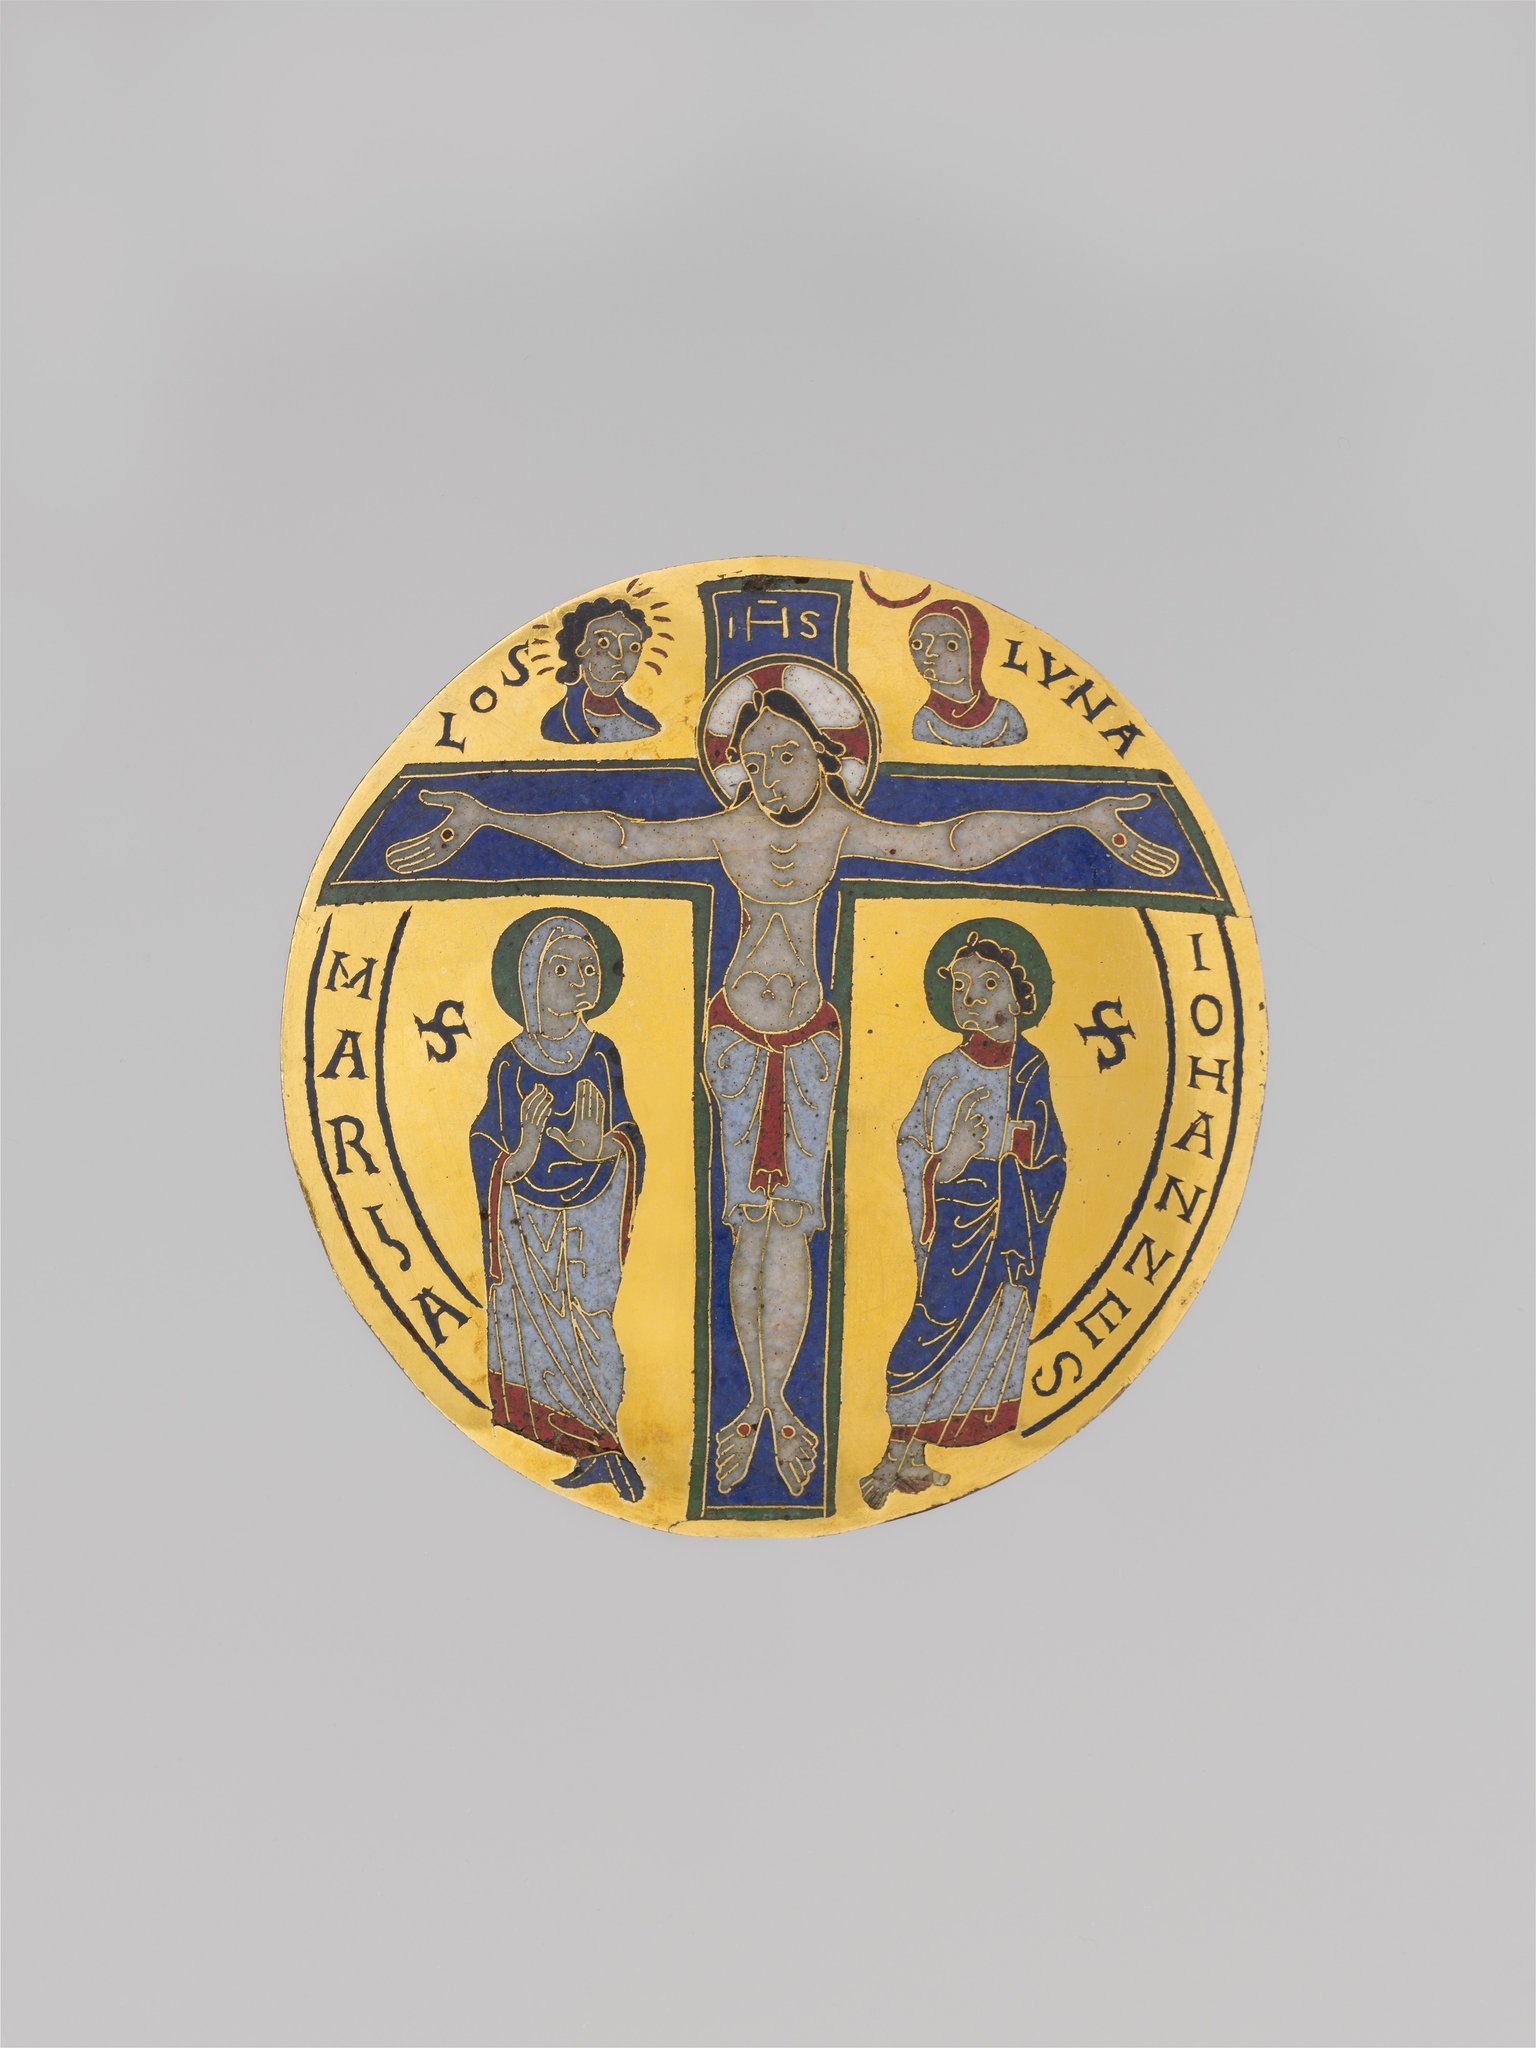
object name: medallion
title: The Crucifixion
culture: french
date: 1100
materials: enamel, gilt copper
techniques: enamel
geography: france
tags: christ,crucifixion